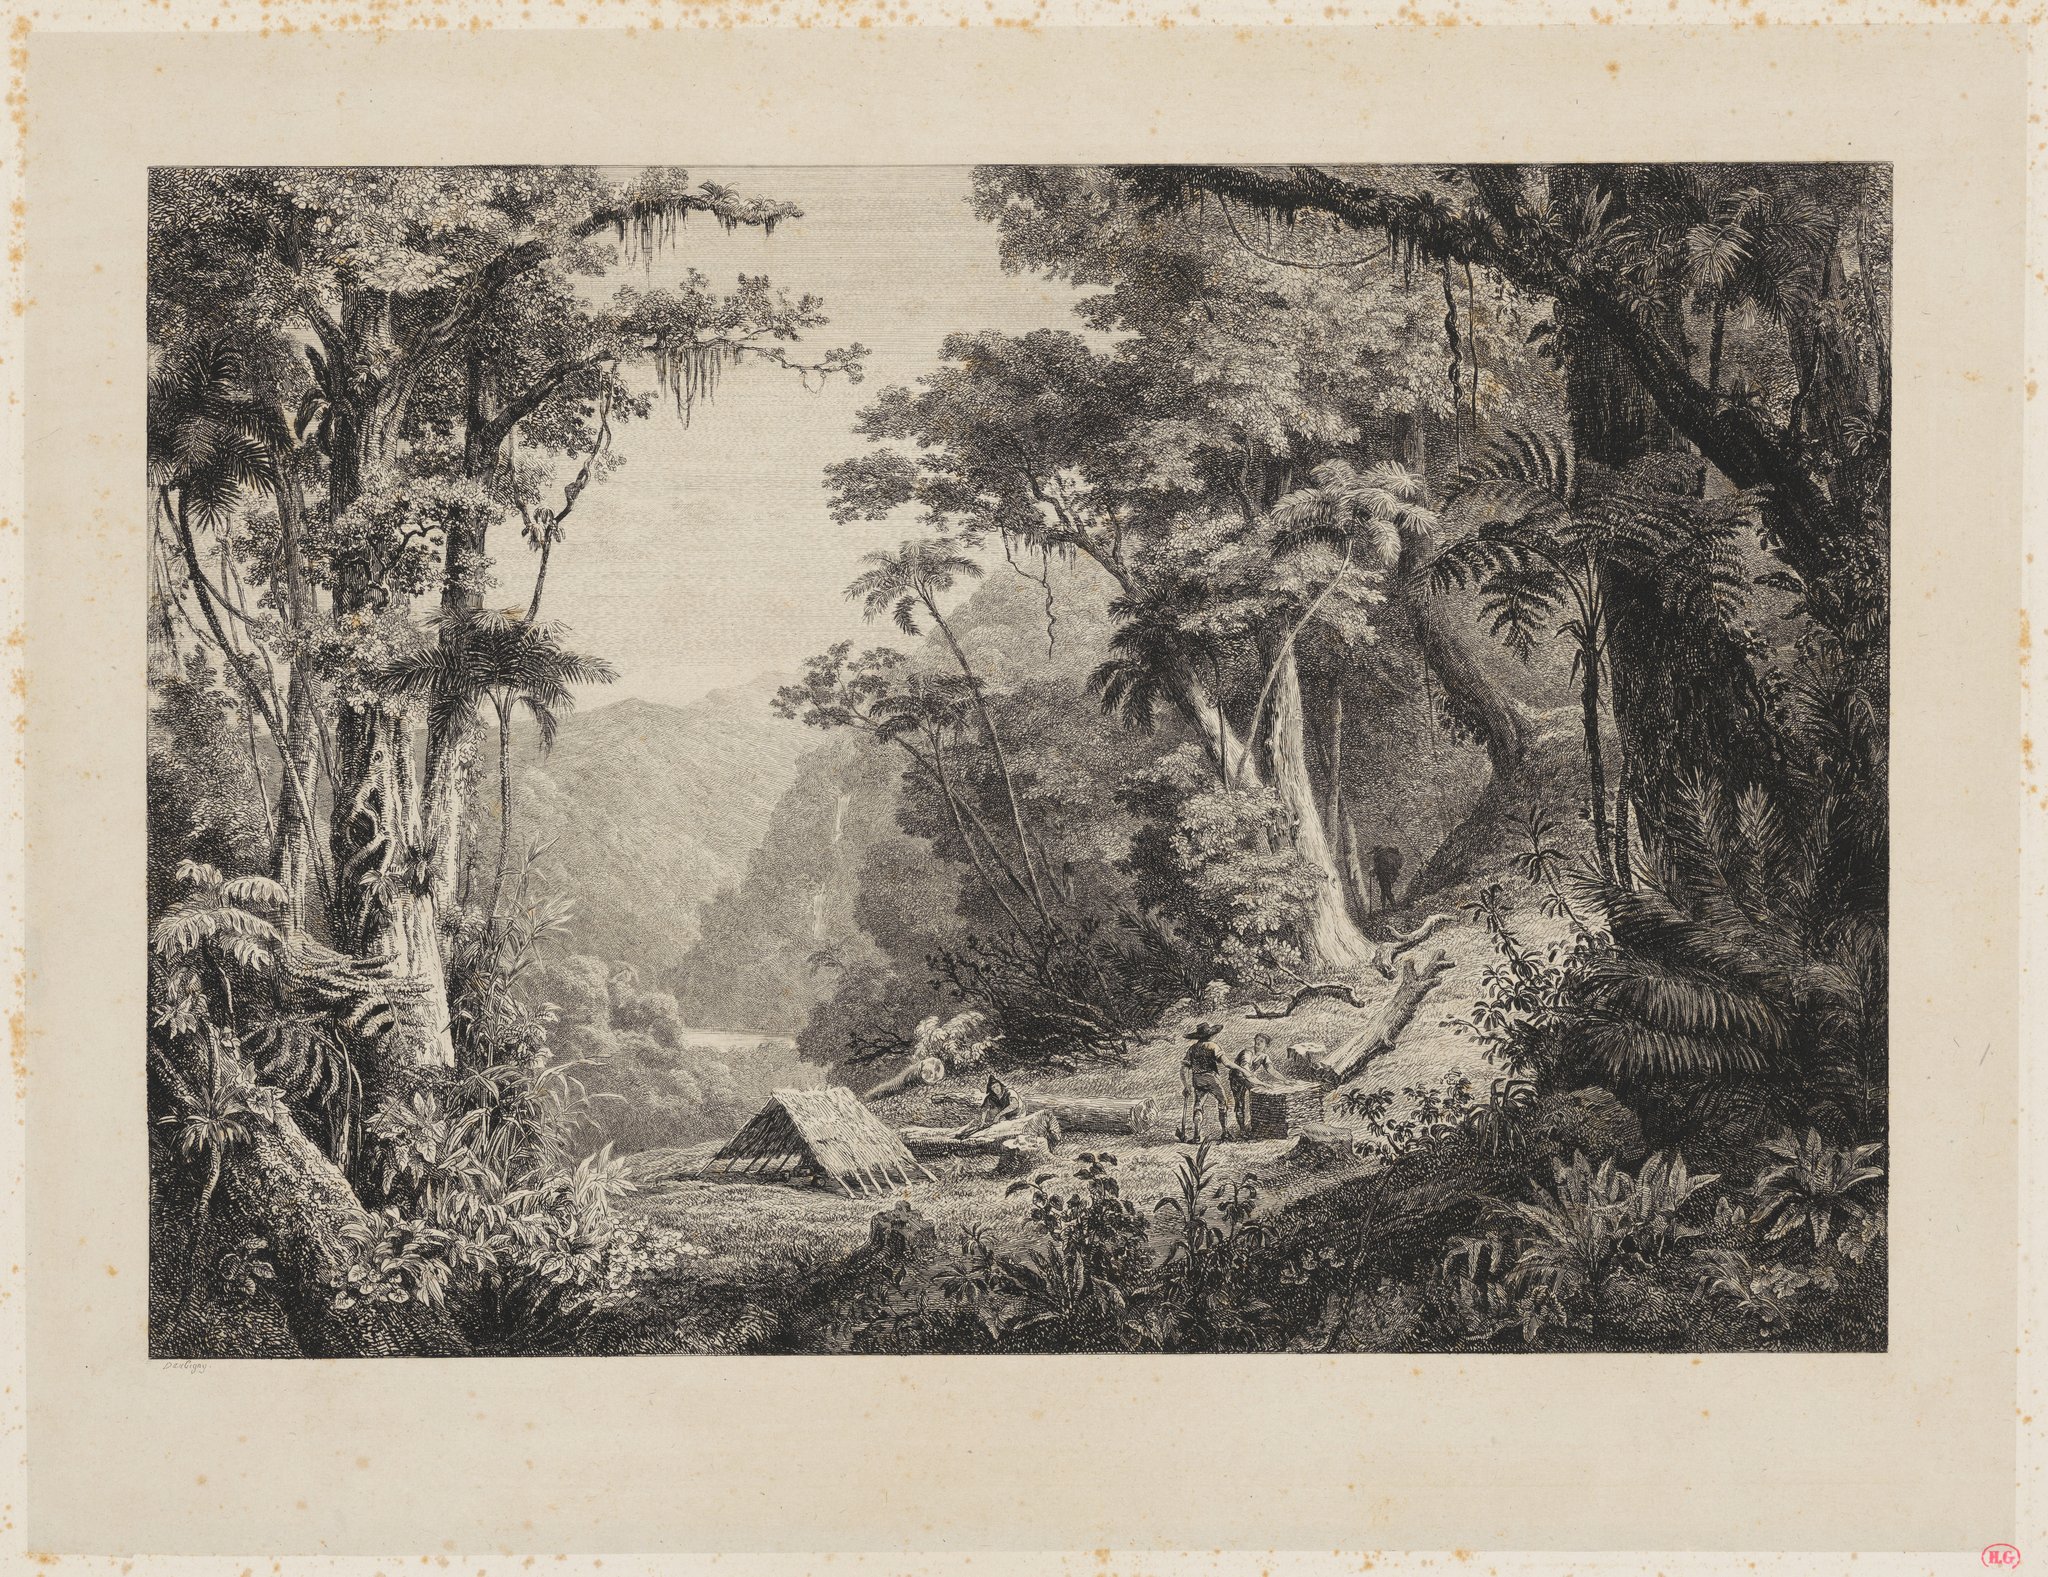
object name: print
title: Valley of San Juan del Oro (Harvesting Cinchona Bark)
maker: charles-françois daubigny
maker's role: etcher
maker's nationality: french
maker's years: 1817-1878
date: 1849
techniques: printmaking, etching